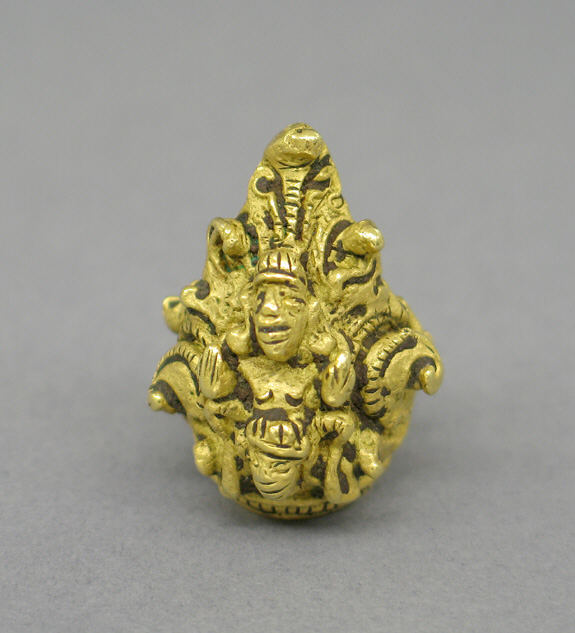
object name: finial clip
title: Rod Finial Clip with Vishnu on Garuda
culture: indonesian, javanese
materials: gold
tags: vishnu